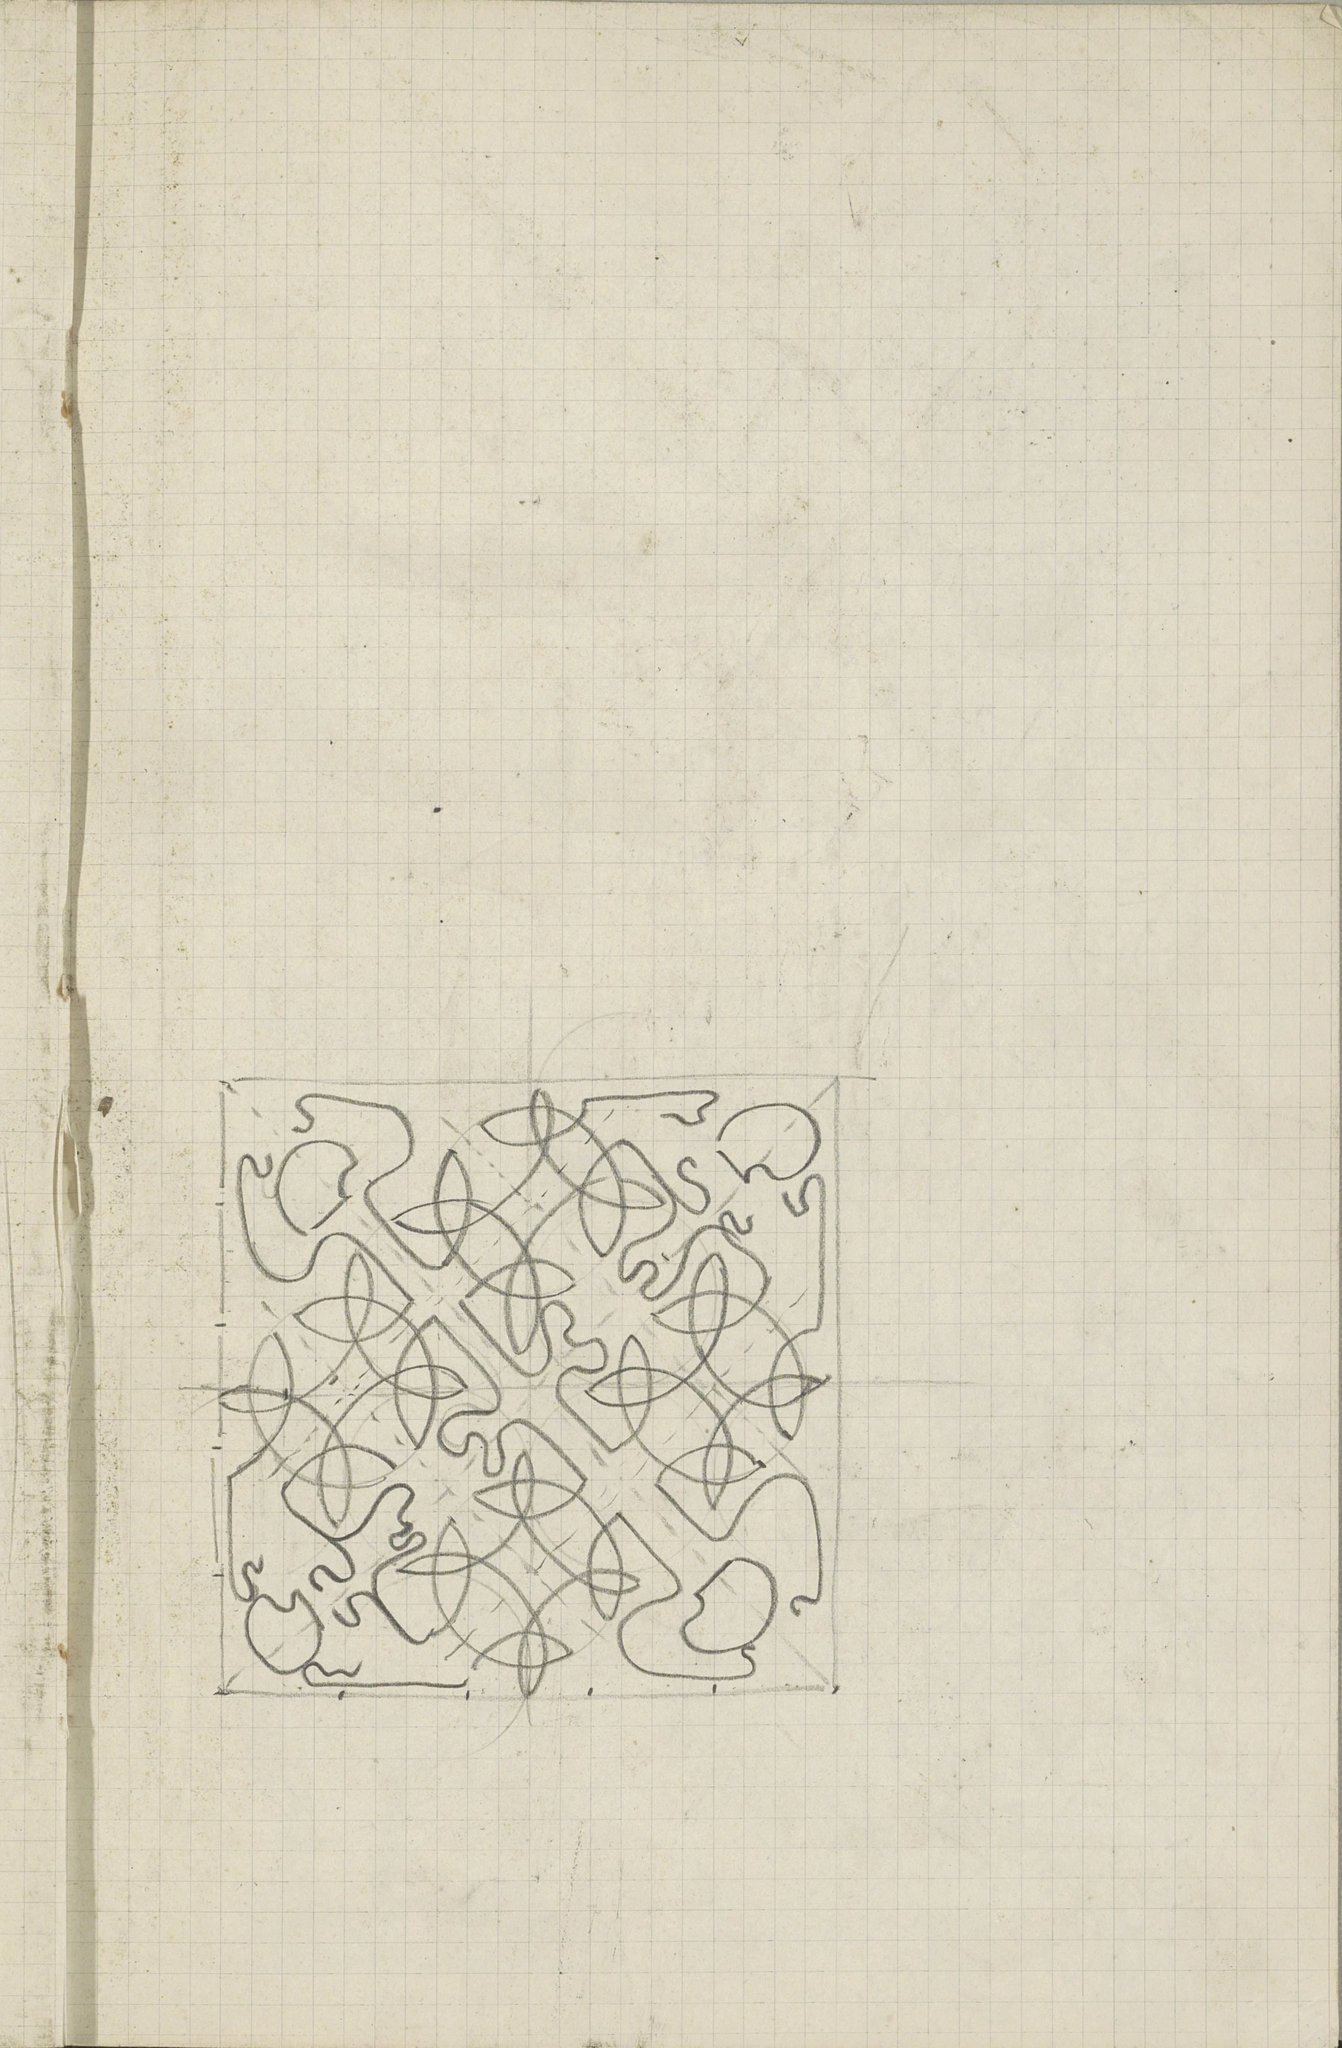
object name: sketchbook leaf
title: Vierkant met daarin een decoratief patroon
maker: carel adolph lion cachet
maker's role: draughtsman, print maker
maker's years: 1864-1945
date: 1874-1945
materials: pencil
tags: ornaments ~ art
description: Blad 7 recto uit een schetsboek met 9 bladen.